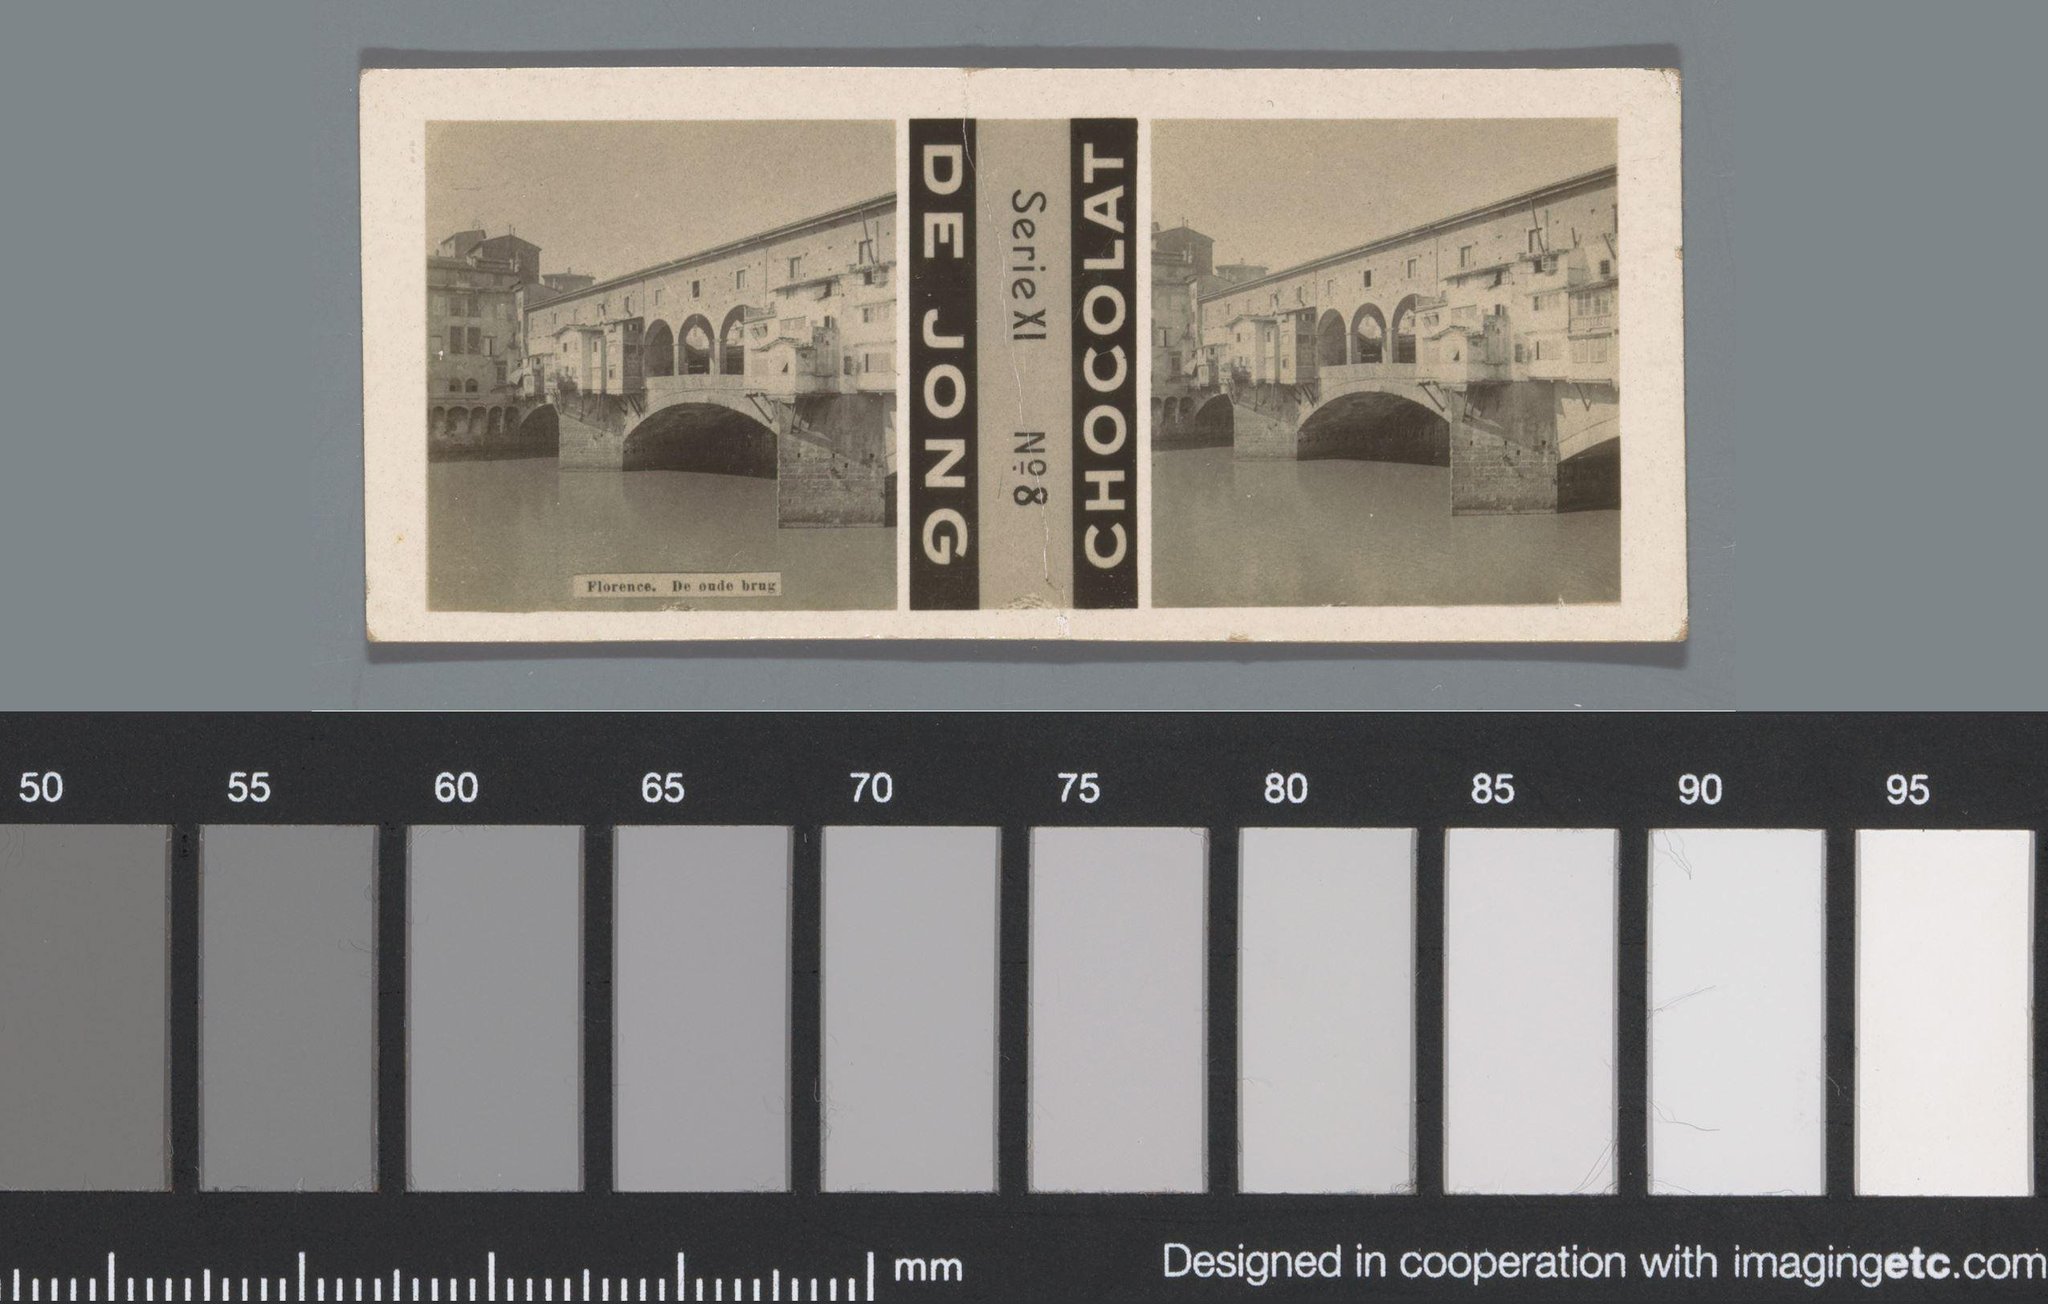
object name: stereograph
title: Gezicht op de Ponte Vecchio te Florence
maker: Anonymous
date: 1900-1910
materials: cardboard, photographic support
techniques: gelatin silver print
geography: wormerveer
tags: bridge in city with structures, i.e. shops, houses, e.g. ponte vecchio in florence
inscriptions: number: ‘Serie XI No 8’, inscription: ‘De Jong chocolat’